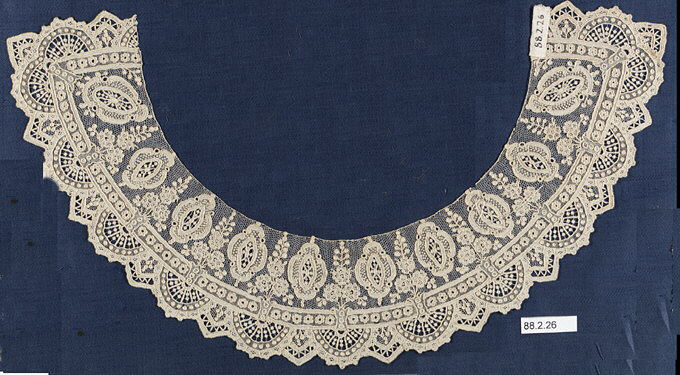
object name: collar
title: Collar lace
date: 1850